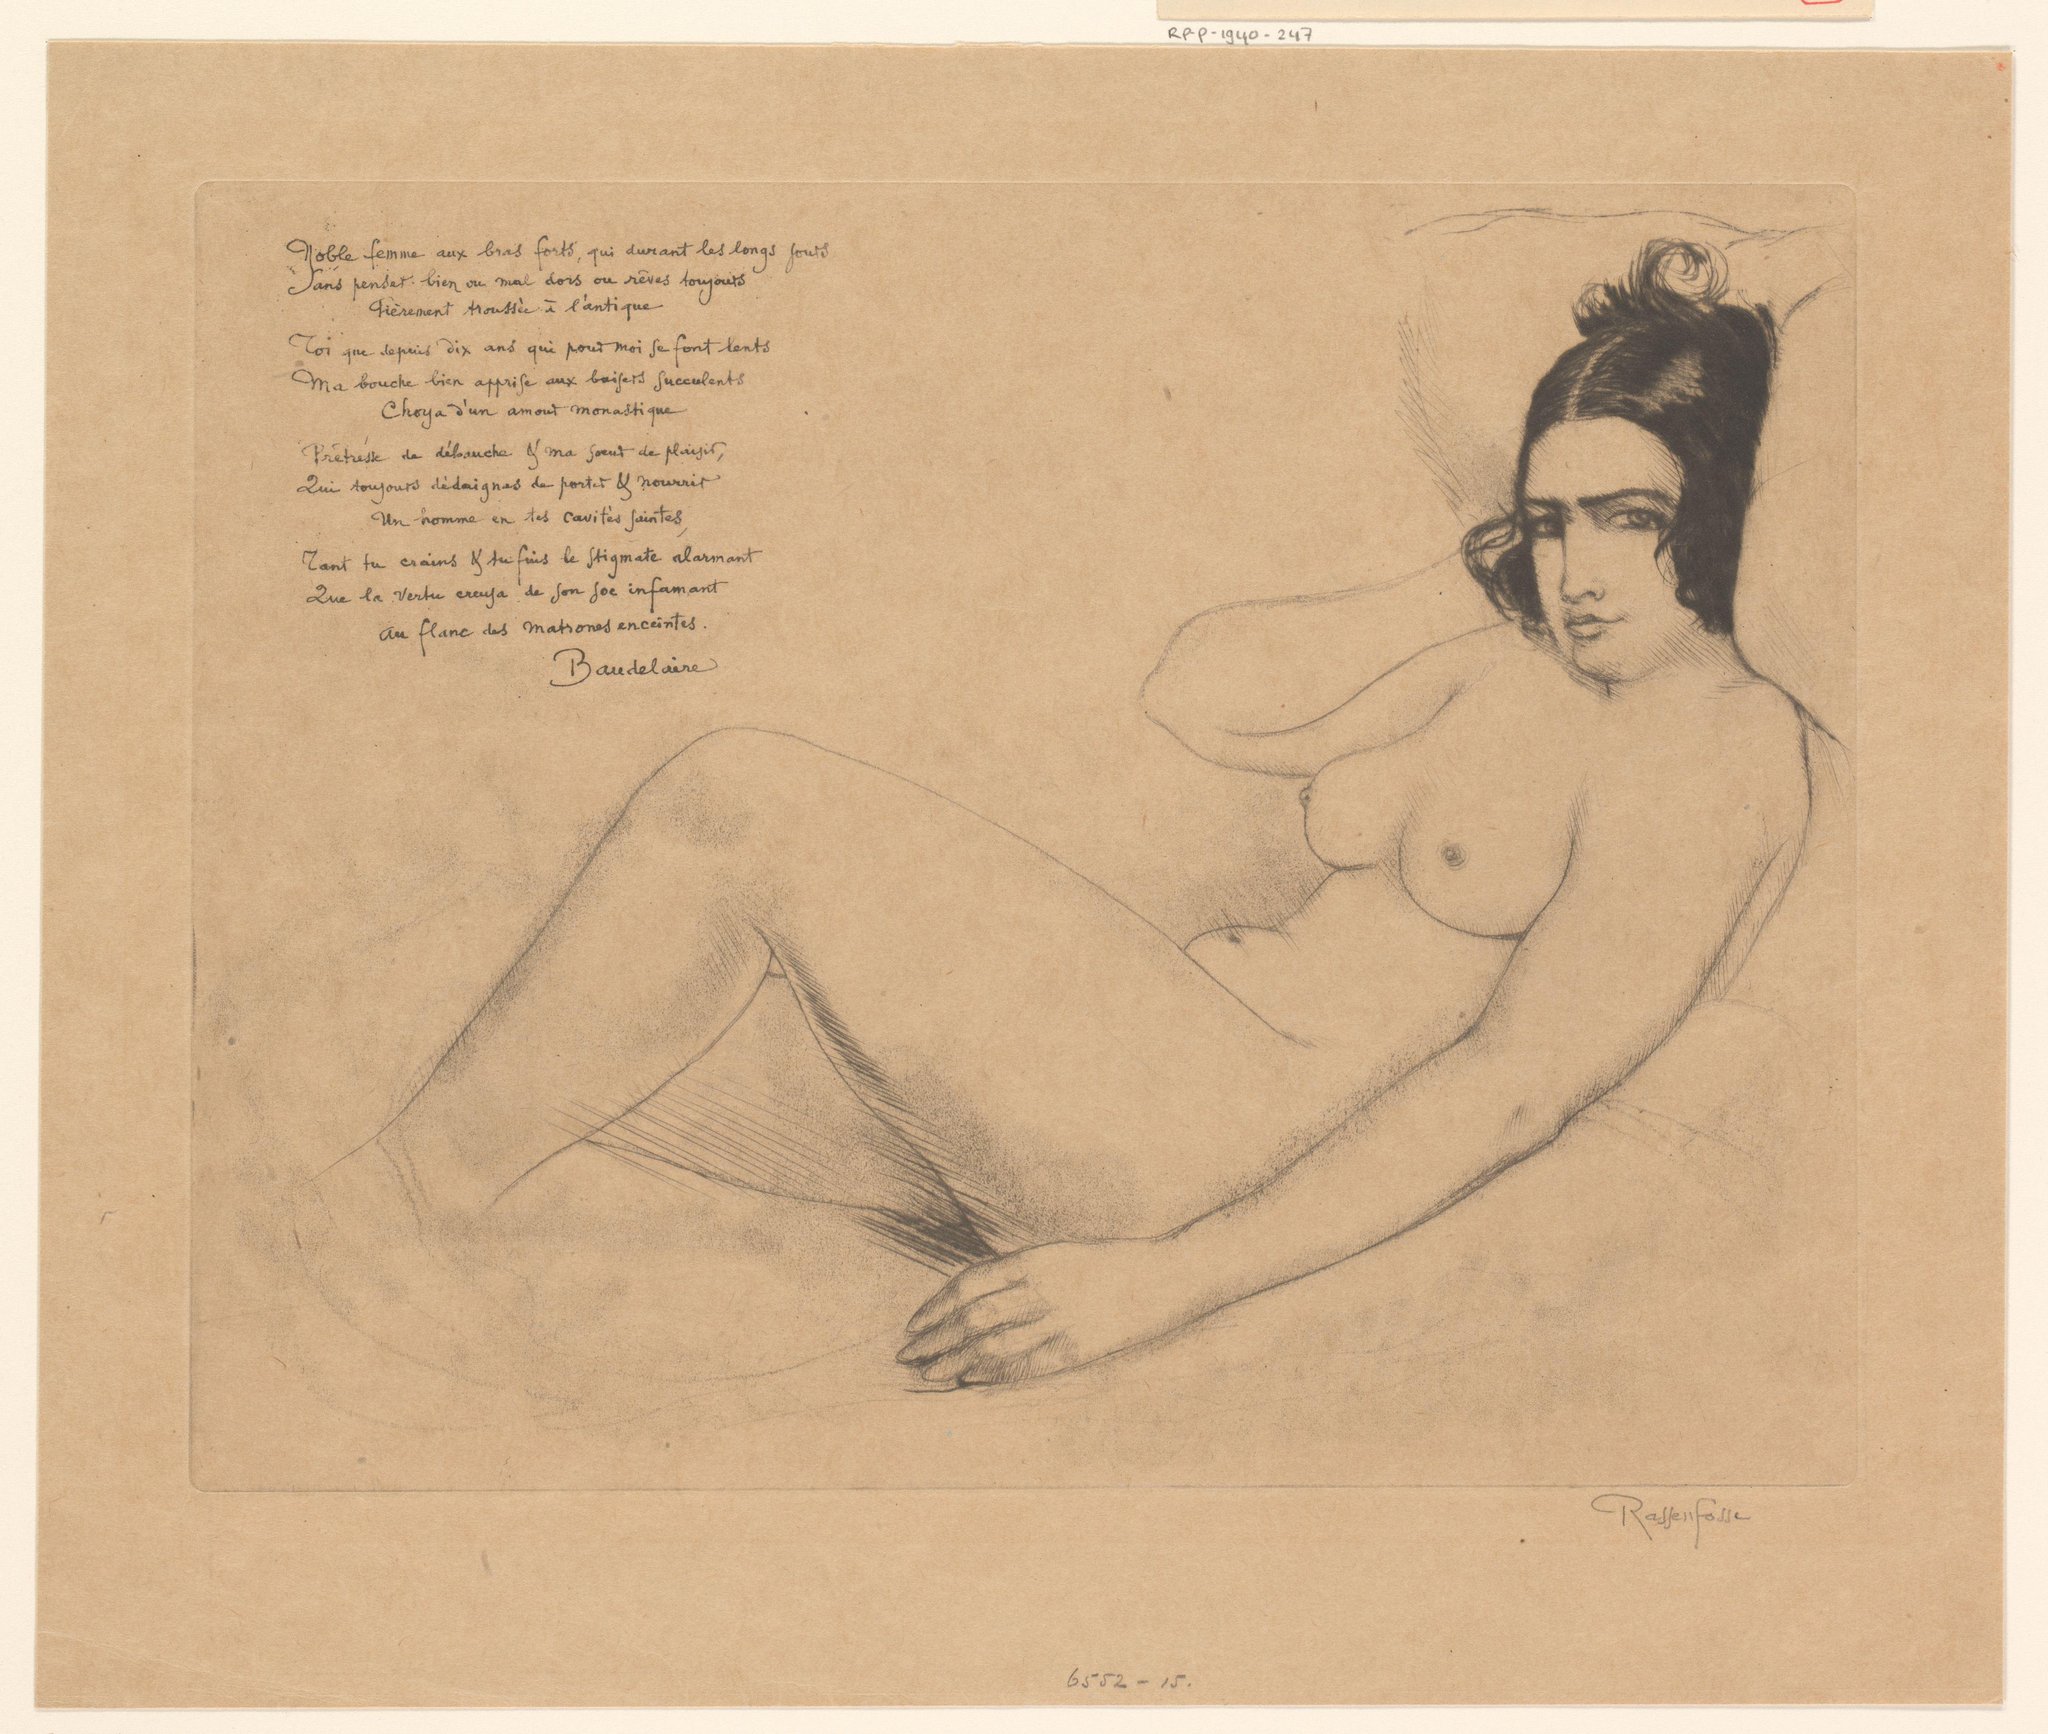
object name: print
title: Liggende naakte vrouw met haar hoofd rustend op een kussen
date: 1930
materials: paper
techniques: drypoint, soft ground etching, sugar lift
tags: pillow, the (nude) human figure; 'corpo humano' (ripa) - aa - female human figure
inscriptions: collector's mark: Lugt 2228, collector's mark: Lugt 2760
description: Linksboven staat een gedicht van Baudelaire.